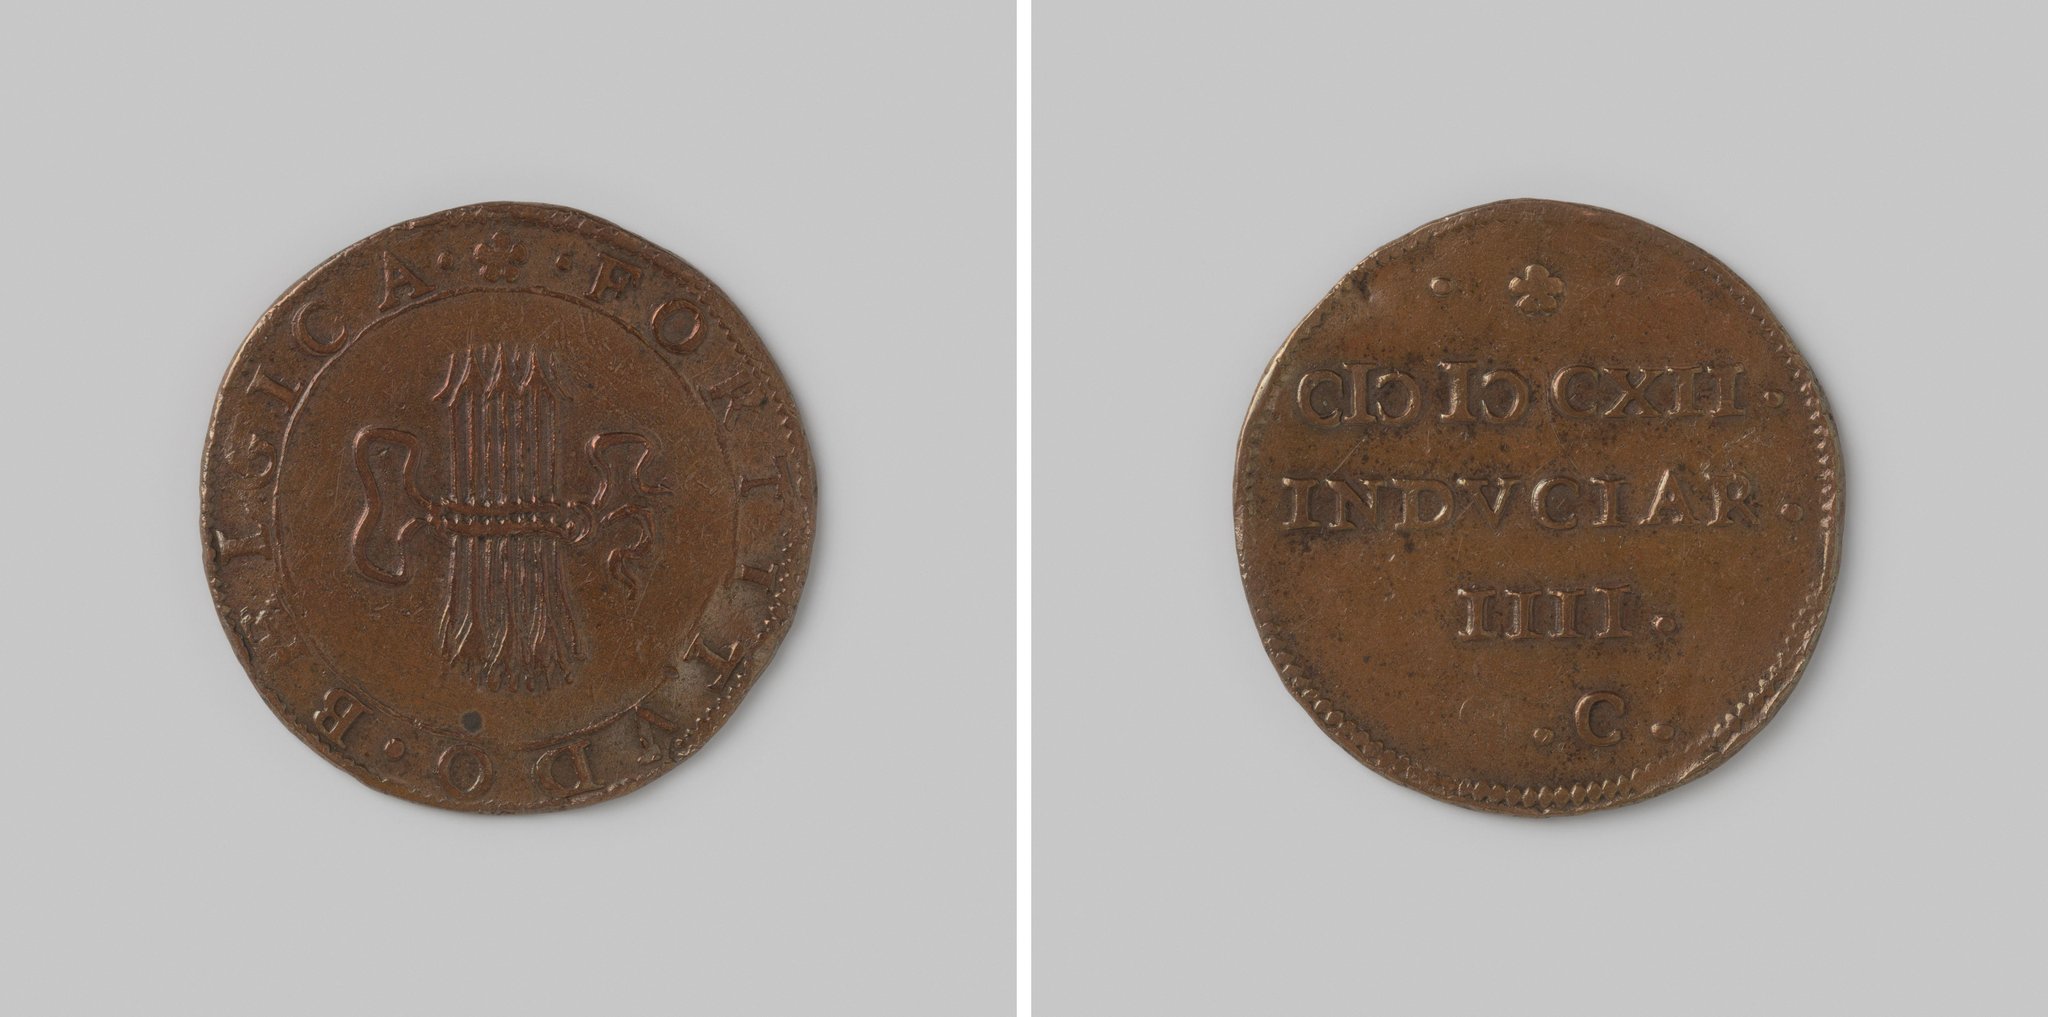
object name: jeton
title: Rekenpenning uit Dordrecht op de kracht van de Nederlanden 1612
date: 1612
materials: copper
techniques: striking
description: Koperen penning, op de voorzijde een pijlenbundel met omschrift, op de keerzijde vier regels tekst.